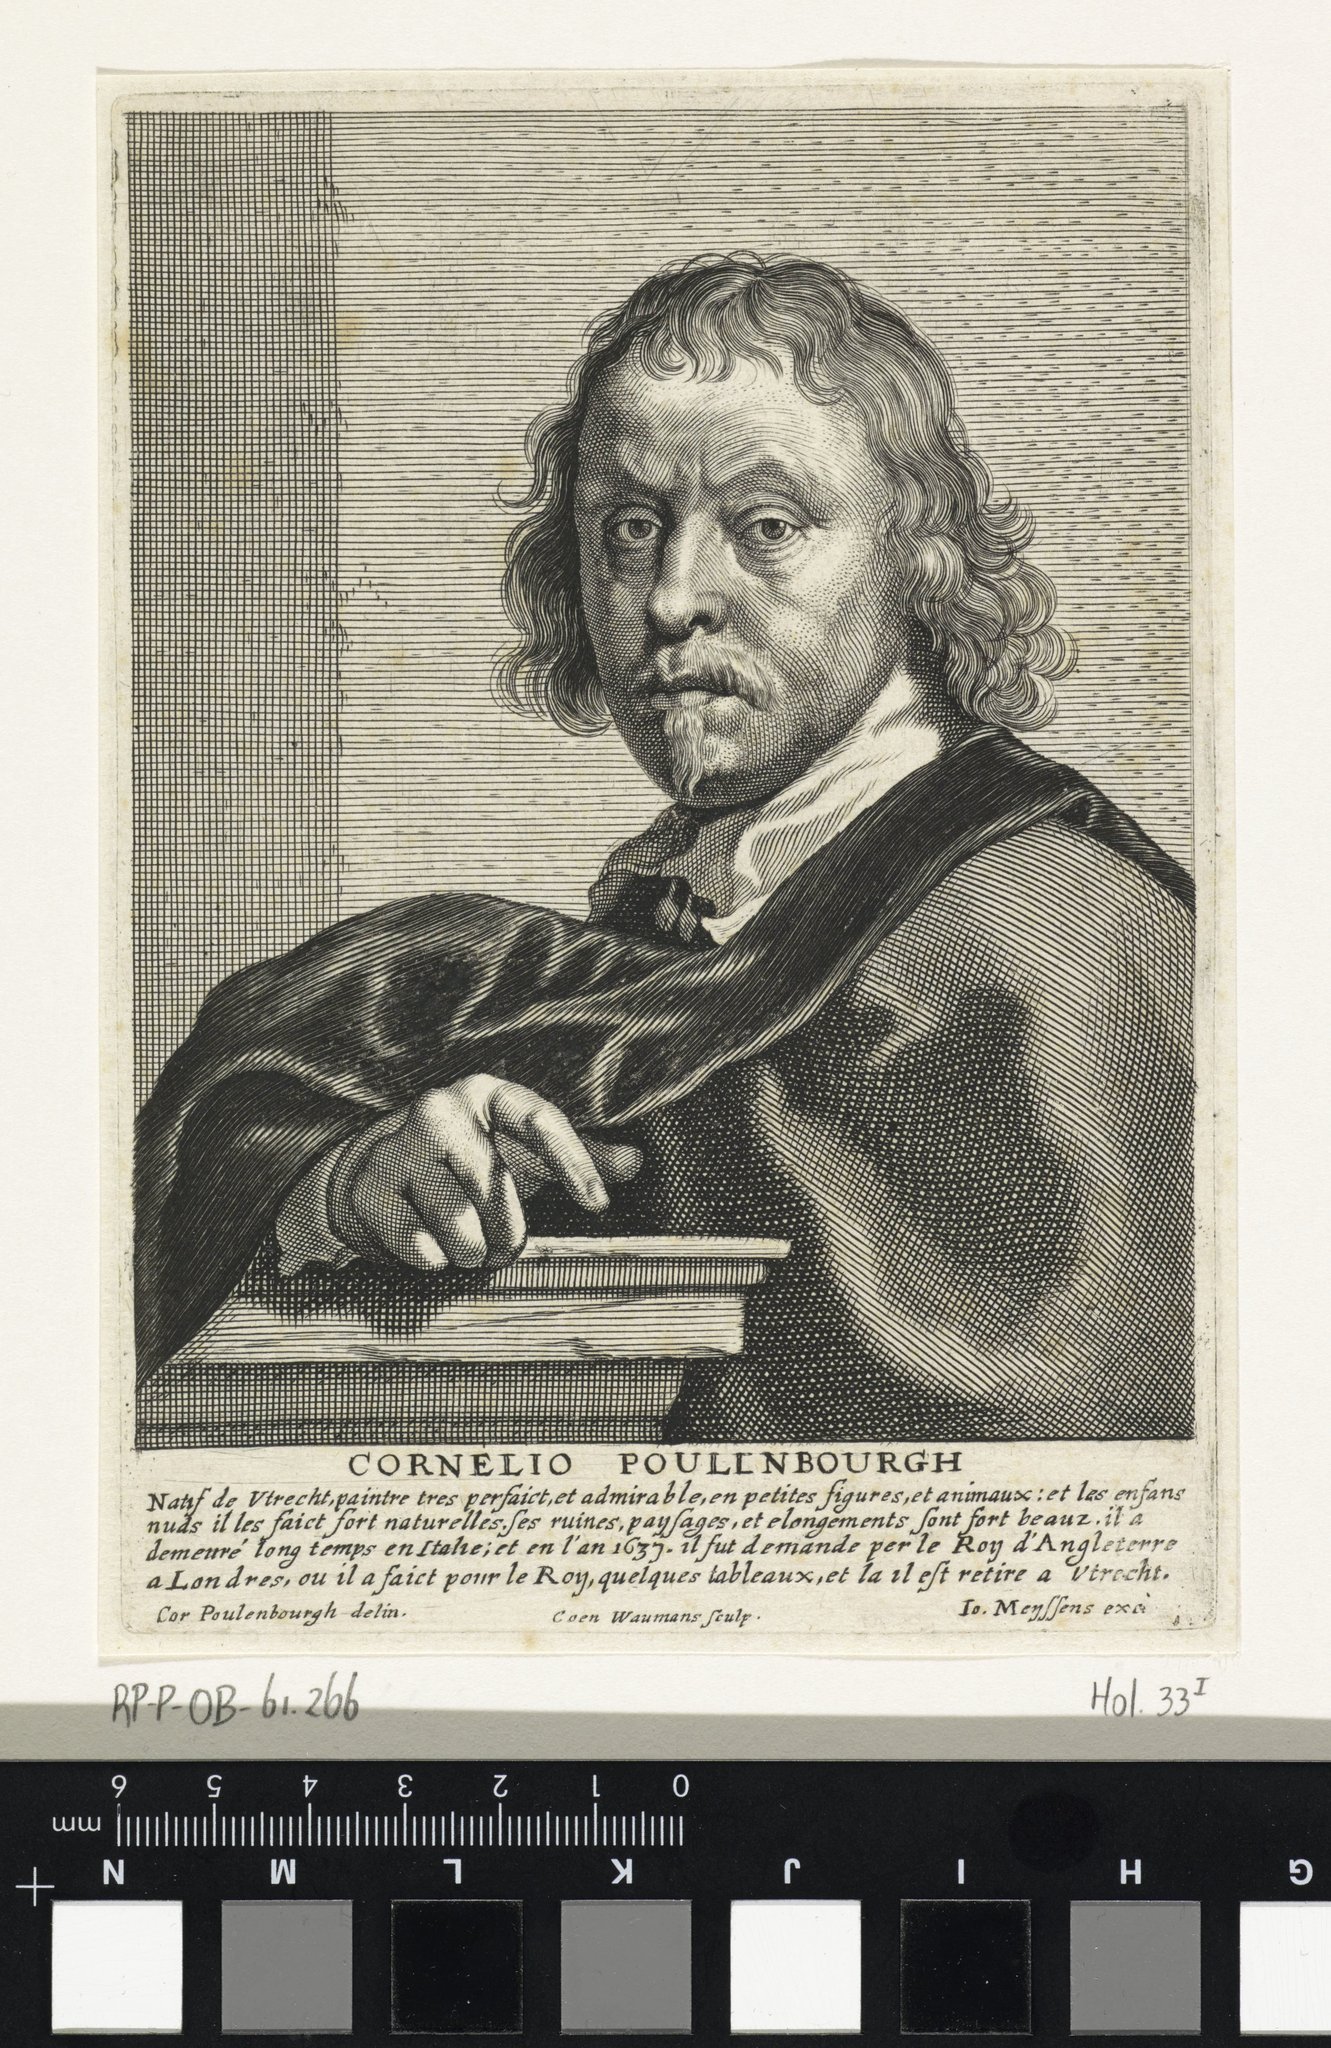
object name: print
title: Portret van de schilder Cornelis van Poelenburch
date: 1649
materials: paper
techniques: engraving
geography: antwerp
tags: utrecht, painter, draughtsman, cornelis van poelenburch, portrait, self-portrait of painter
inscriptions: collector's mark: Lugt 2228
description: Prent gebruikt in: Image de divers hommes d'esprit sublime, qui par leur art et science devraient vivre éternellement et desquels la louange et renommée faict estonner le monde. Antwerpen: J. Meyssens, 1649.